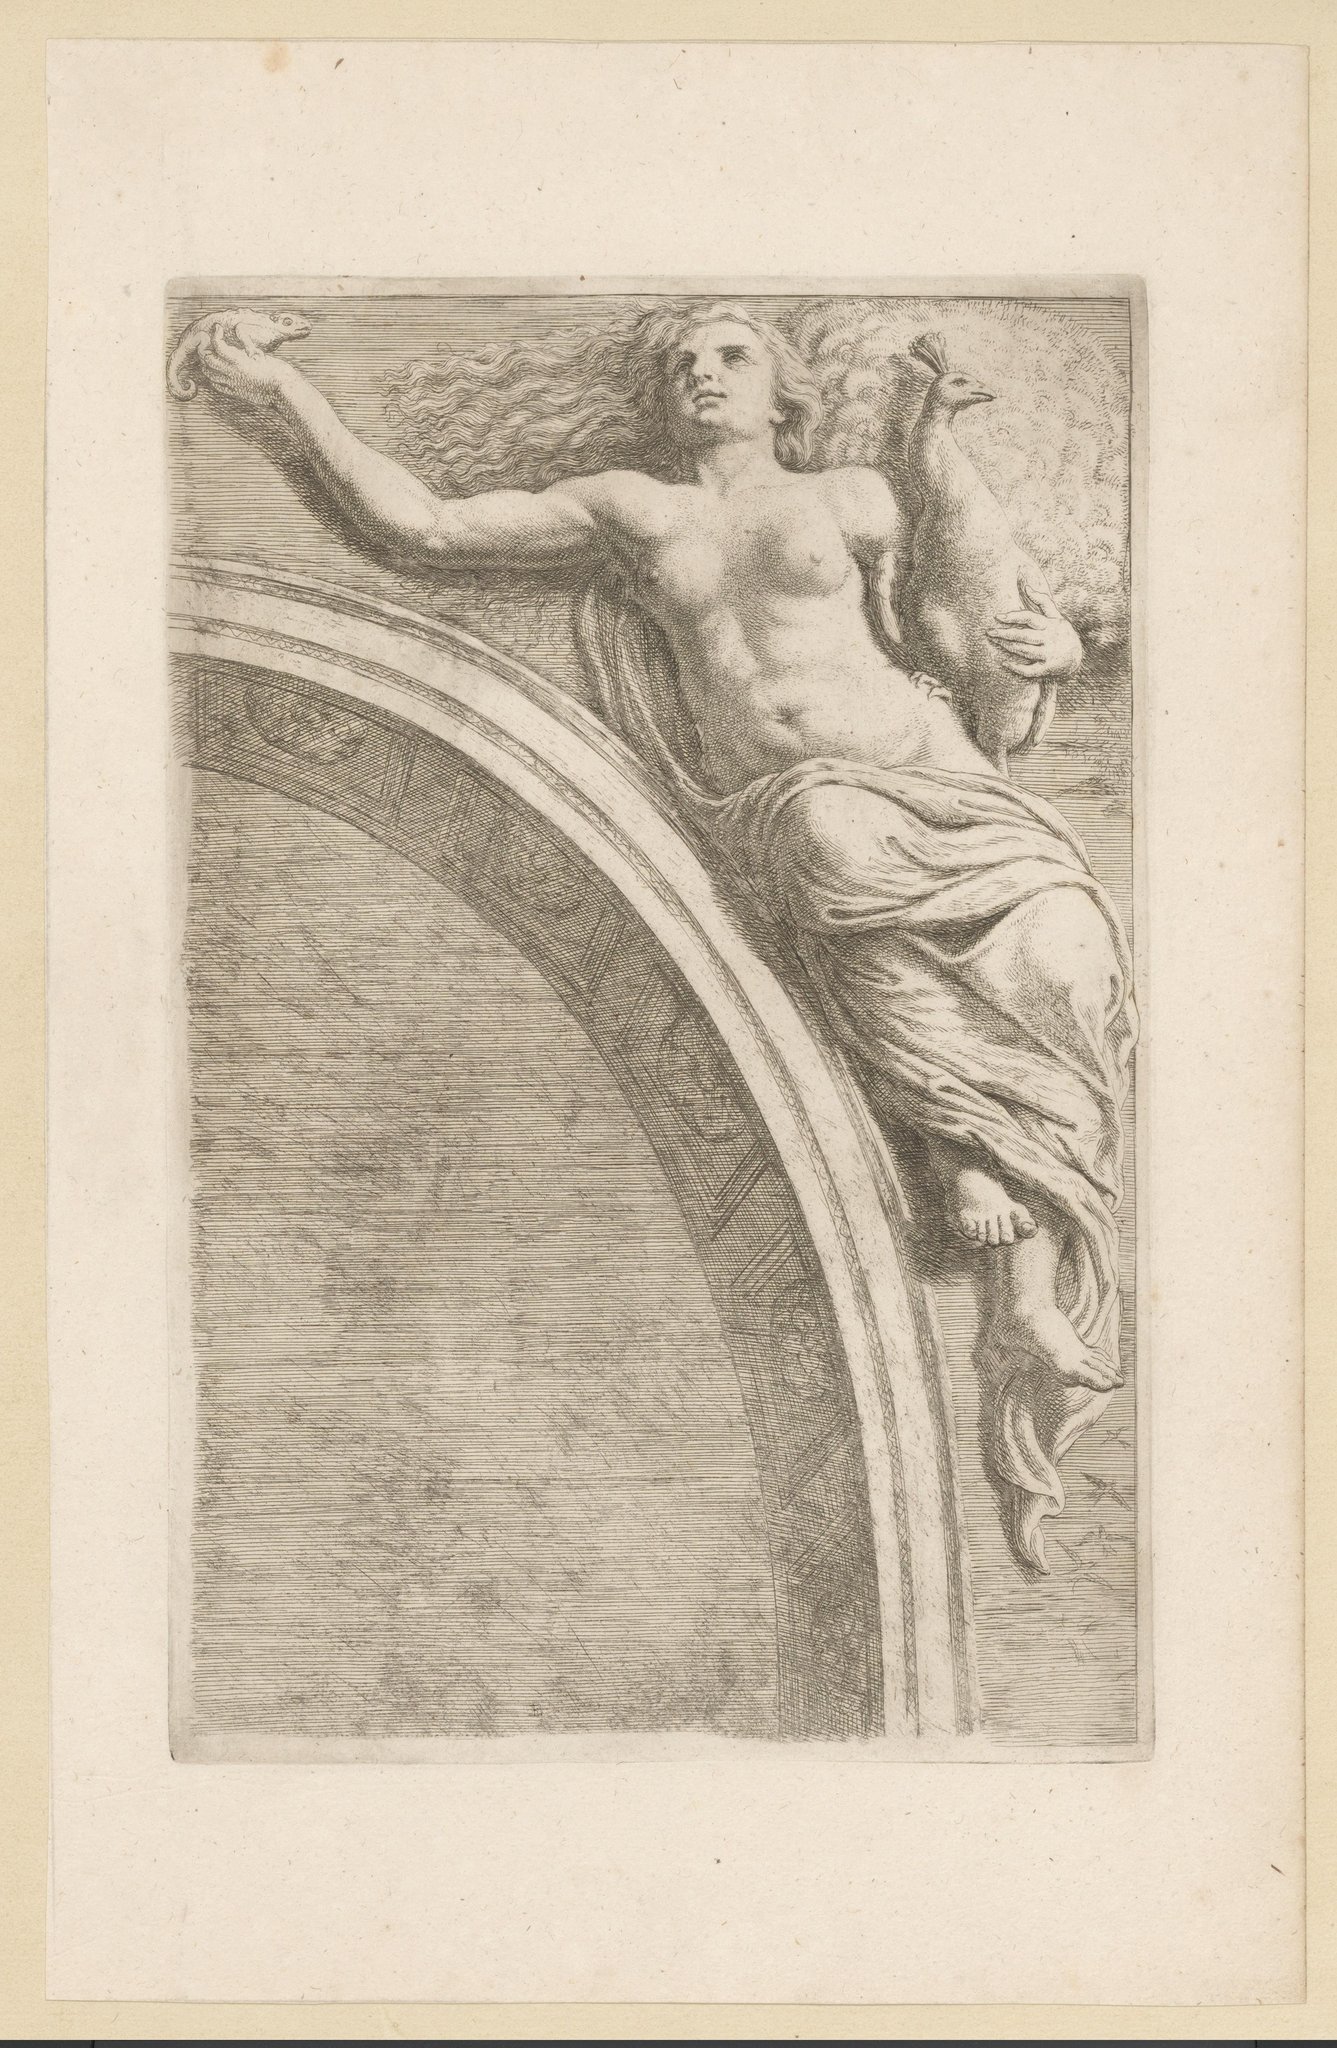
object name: print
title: Reliëf met personificatie van het element Lucht boven boog aan westzijde van de Burgerzaal in het Stadhuis op de Dam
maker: hubert quellinus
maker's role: print maker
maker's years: 1619-1687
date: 1663-1668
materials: paper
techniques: engraving, etching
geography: amsterdam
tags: air (one of the four elements), ornamental birds: peacock, townhall, lizards: chameleon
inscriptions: collector's mark: ‘16,73’ Lugt 1641b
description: Huidige staat van prent ook gebruikt in: Secunca pars Praecipuarum effigierum ac ornamentorum amplissime Curiae Amstelrodamensis maiori ex parte in cadido marmore effectorum per Artum Quellinium eiusdem Civitatis Statuarium / Het tweede deel Van de voornaemste Statuen ende Cieraten van 't konst-rijcke Stadt-huys van Amstelredam 'tmeeste in Marmer gemaeckt door Artus Quellinus Beelthouwer der voorseyde Stadt. Amsterdam: Artus Quellinus (I), 1663. En in: Secunca pars Praecipuarum effigierum ac ornamentorum amplissime Curiae Amstelrodamensis maiori ex parte in cadido marmore effectorum per Artum Quellinium eiusdem Civitatis Statuarium / Het tweede deel Van de voornaemste Statuen ende Cieraten van 't konst-rijcke Stadt-huys van Amstelredam 'tmeeste in Marmer gemaeckt door Artus Quellinus Beelthouwer der voorseyde Stadt. Amsterdam: Frederik de Wit, 1668. Latere staat van prent ook gebruikt in: Architecture peinture et sculpture de la Maison de Ville d'Amsterdam, representee en CIX. figures en taille-douce (…). Amsterdam: David Mortier, 1719. En in: Architecture peinture et sculpture de la Maison de Ville d'Amsterdam, representee en CIX. figures en taille-douce (…). Amsterdam: Gerard Valck, 1719. En in: Bouw schilder en beeldhouwkonst, van het Stadhuis te Amsteldam, vertoont in CIX figuuren (…). Amsterdam: Covens & Mortier & Covens Jr., s.a. (1774-1783).